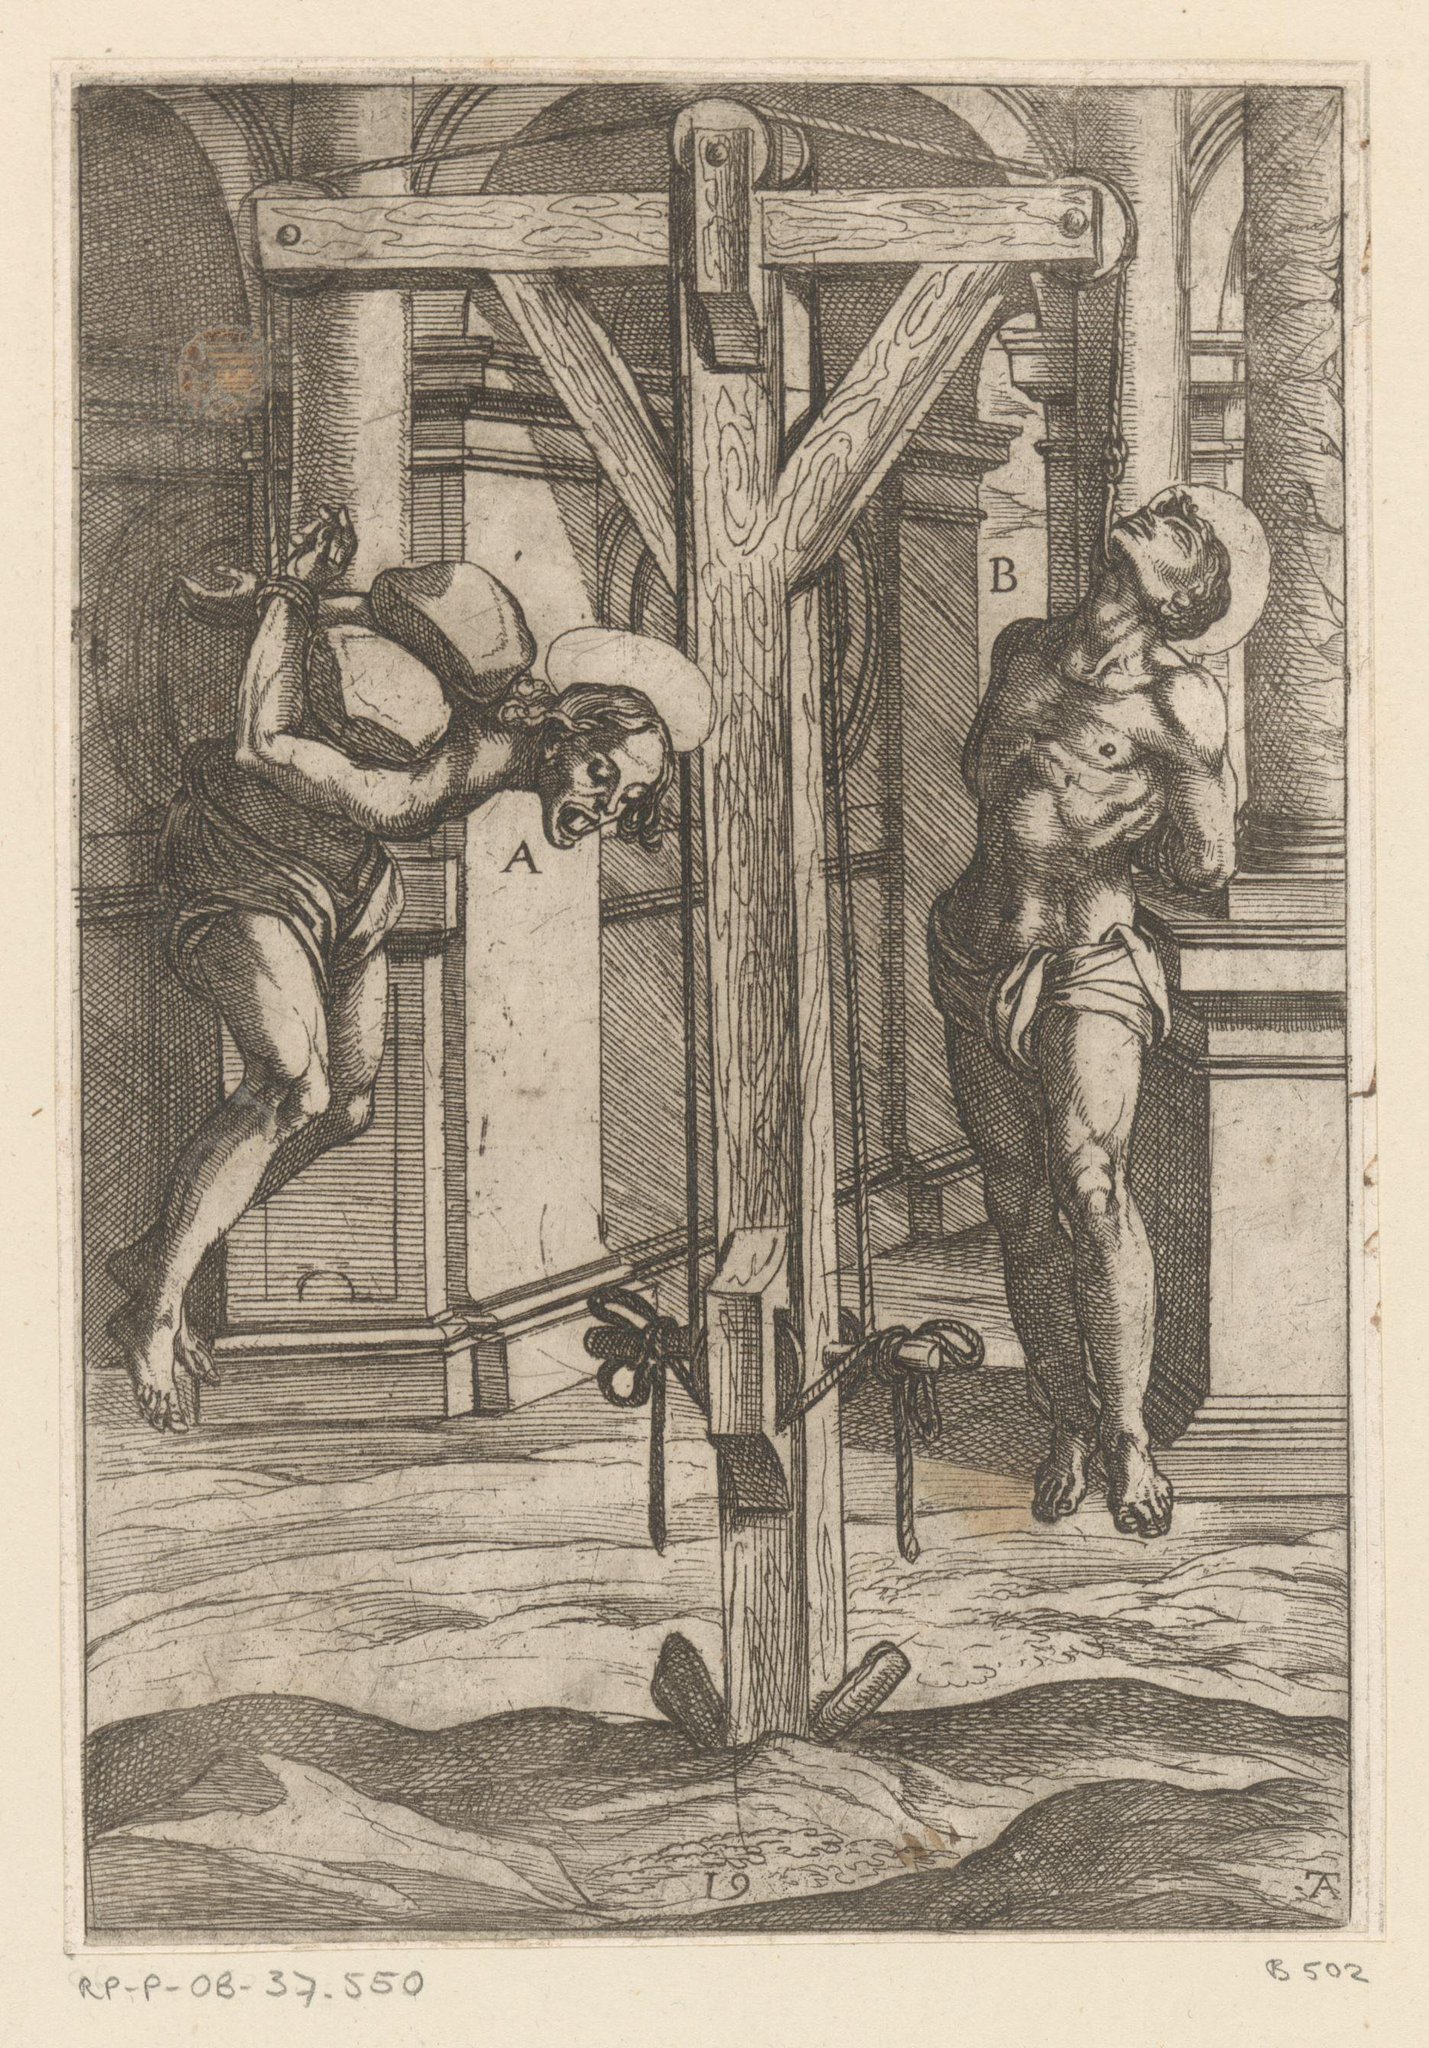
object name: print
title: Varia tormentorum et supplicioru crudelium (...)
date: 1565-1630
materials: paper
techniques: etching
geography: italy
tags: violent death ~ maltreatment, torture, torture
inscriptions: collector's mark: Lugt 240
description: Deze prent maakt deel uit van een reeks van 47 prenten (+ titelprent) met voorstellingen van martelmethoden. Deze prenten zijn in een andere editie gebruikt als illustraties voor Antonio Gallonio's 'Trattato degli Instrumenti di Martirio e delle Varie Maniere di Martoriare Usate dai Gentili contro Christiani' (Rome, Ascanio en Girolamo Dongangeli, 1591).